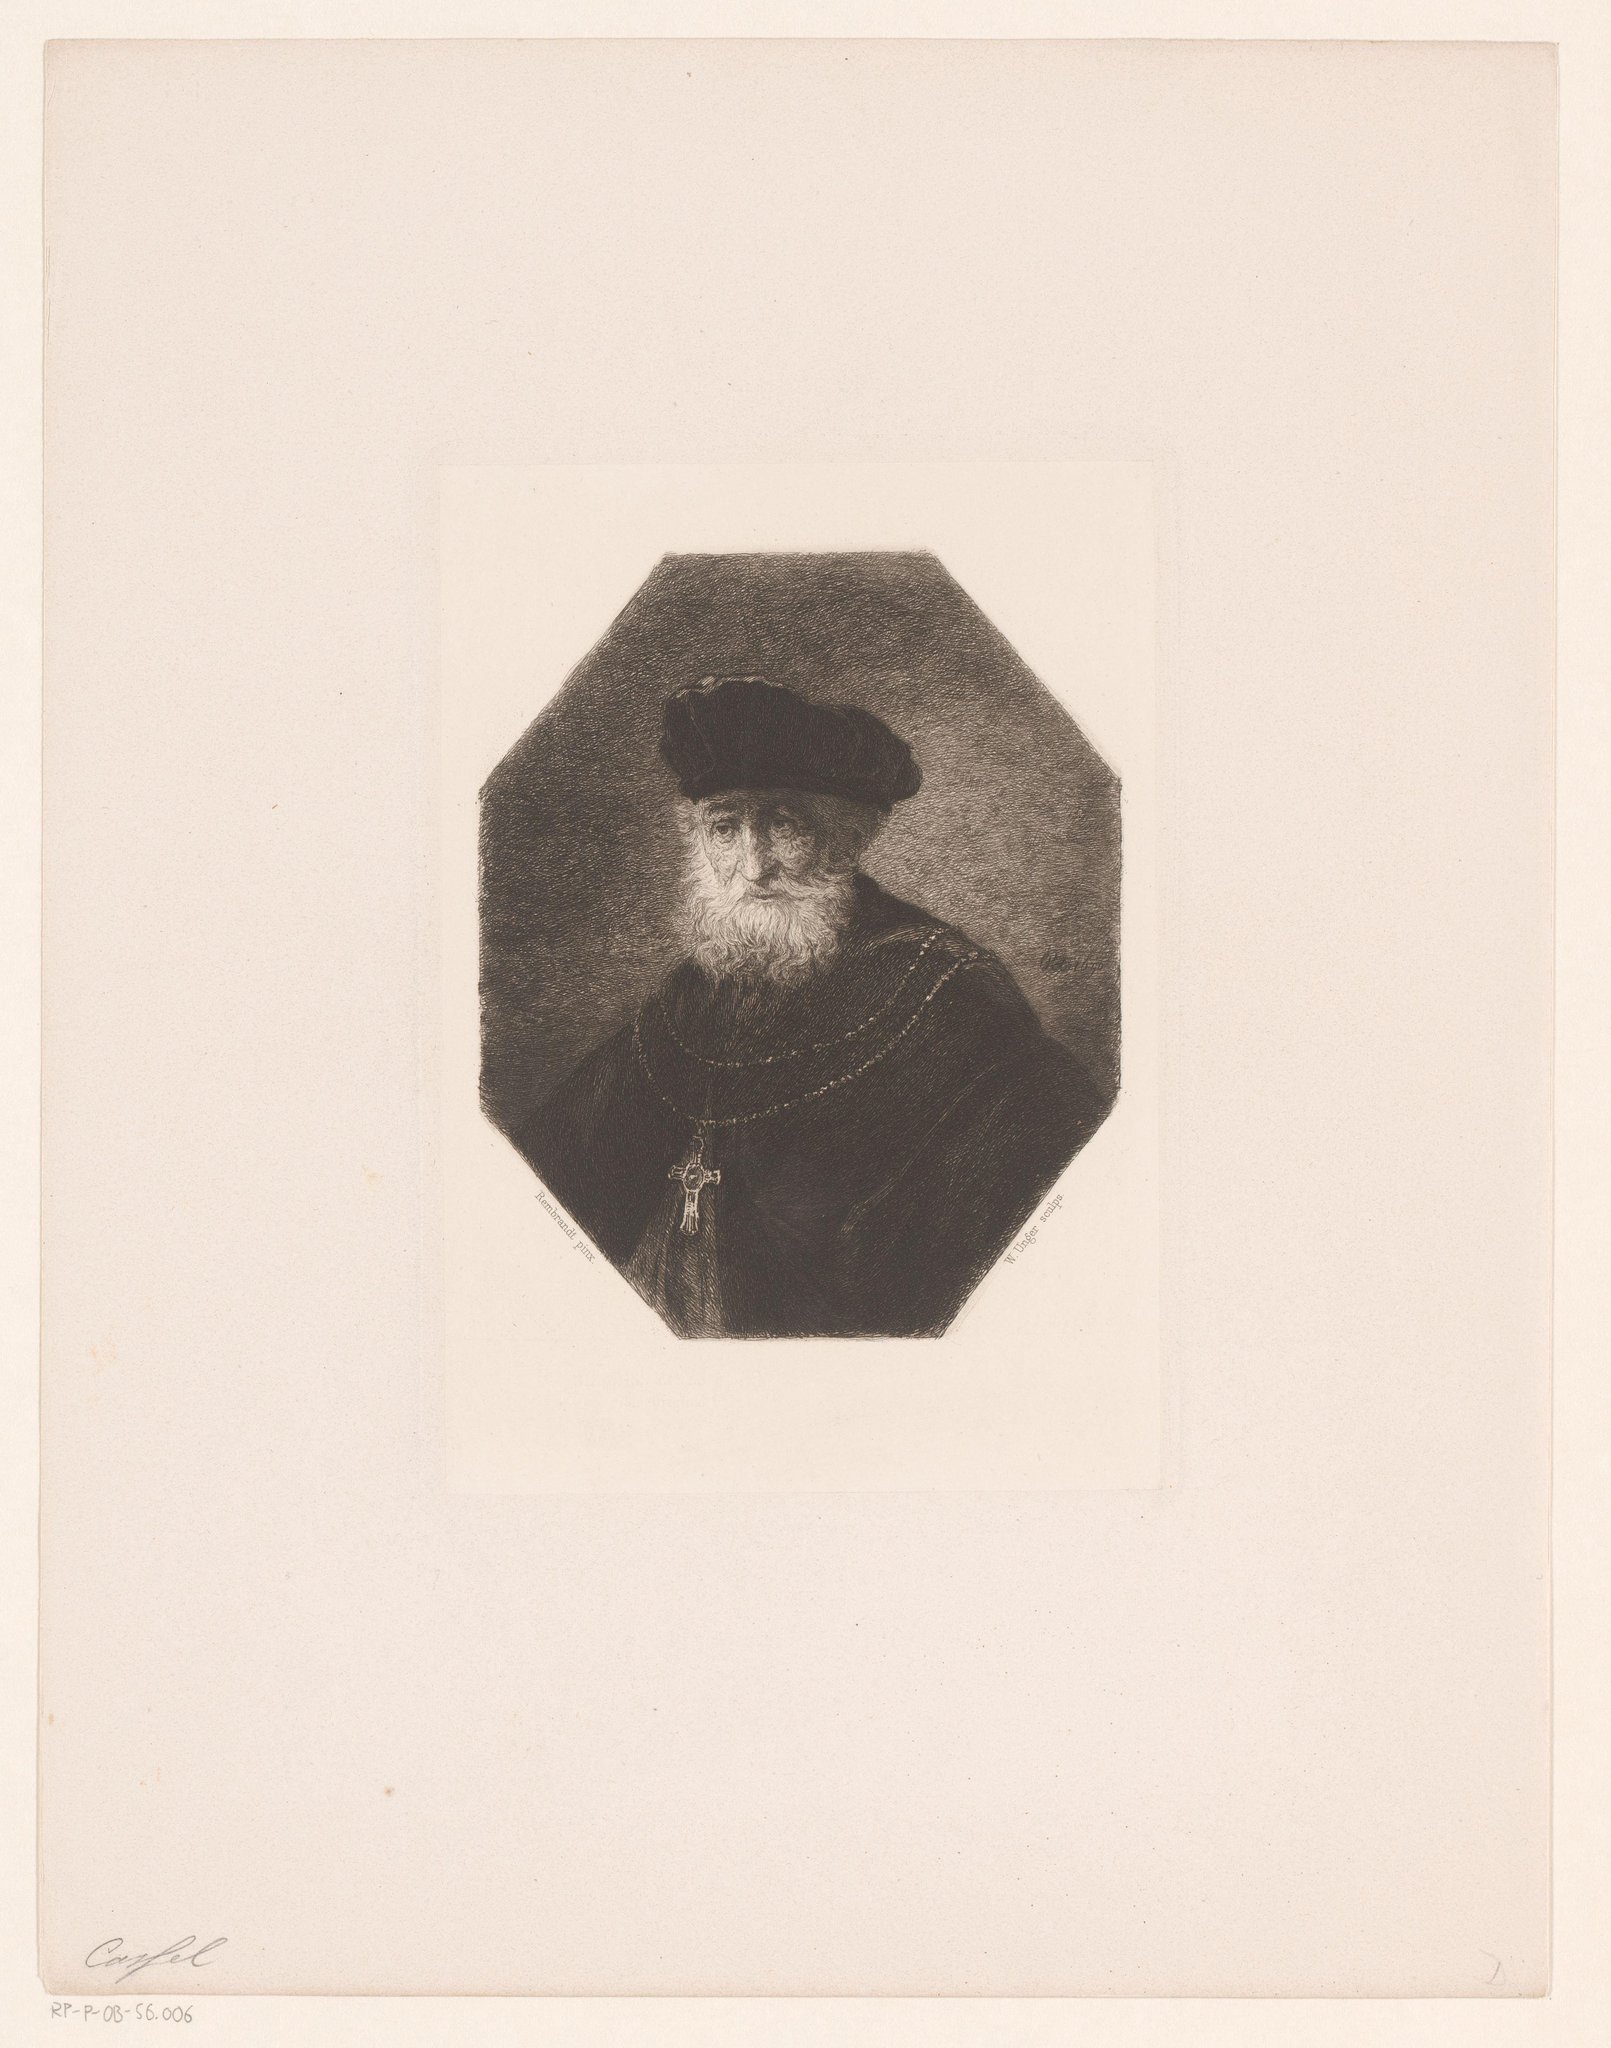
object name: print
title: Oude man met een baret en ketting met kruis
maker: william unger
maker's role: draughtsman, painter, print maker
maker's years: 1837-1932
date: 1847-1889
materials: paper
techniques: etching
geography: germany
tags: old man, head-gear: hat, beard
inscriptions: collector's mark: Lugt 2228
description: Prent naar het schilderij door een navolger van Rembrandt Harmensz. van Rijn in de Gemäldegalerie Alte Meister te Kassel (inv.nr. GK 231).